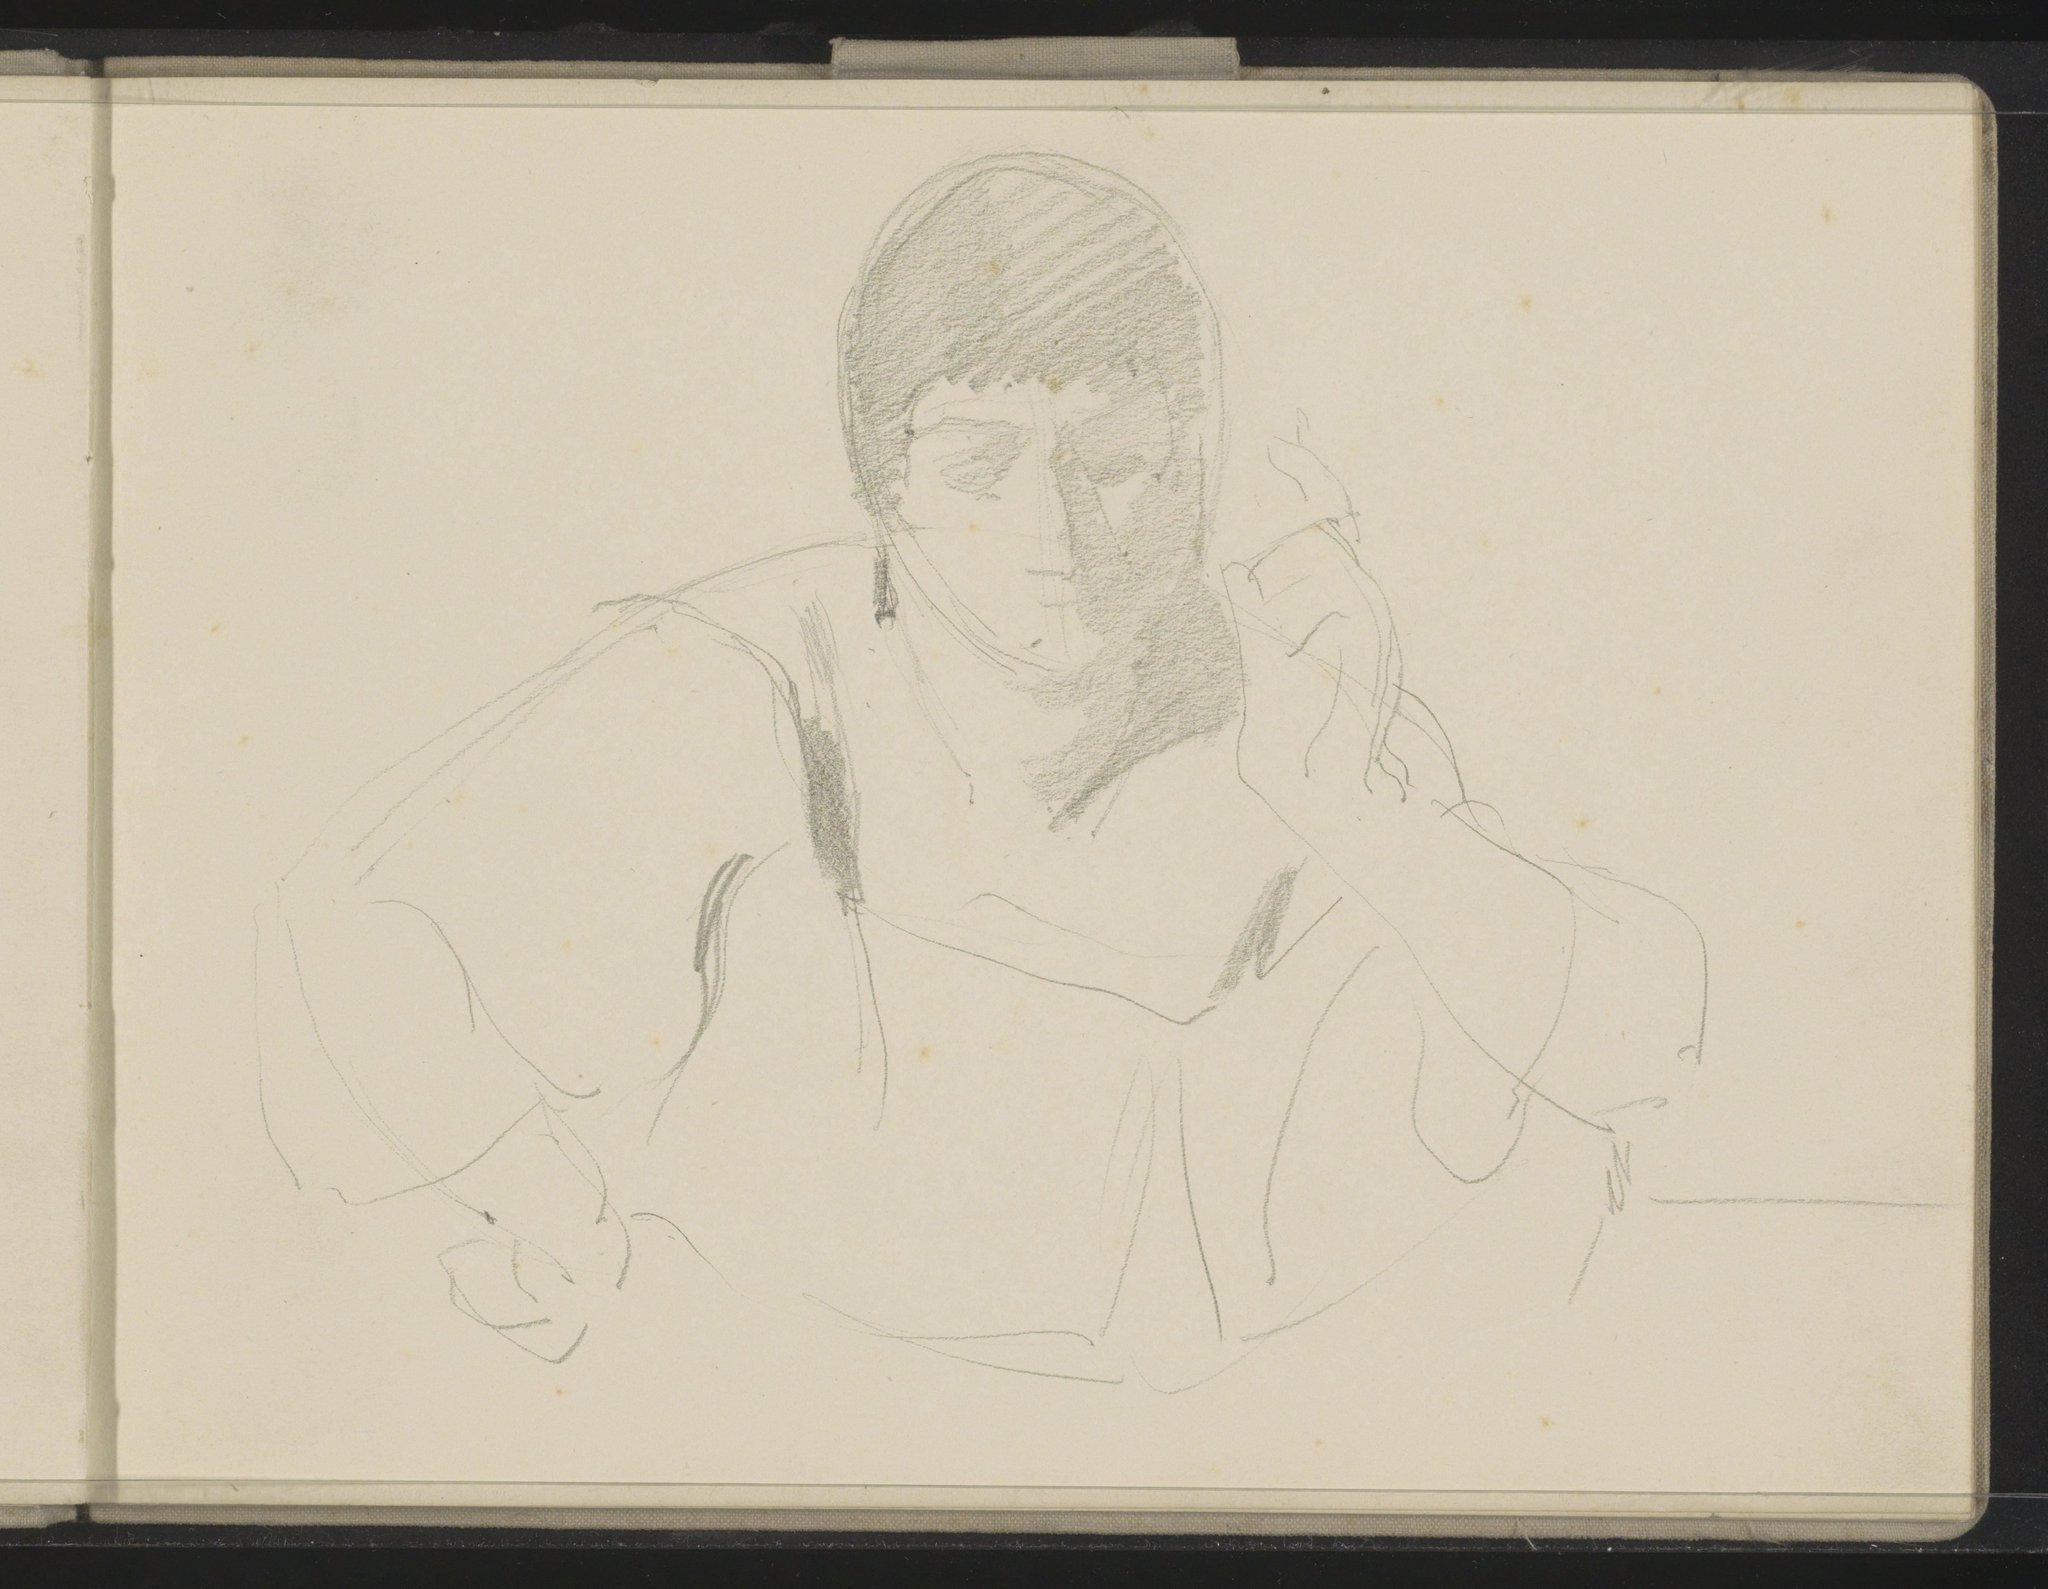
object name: sketchbook leaf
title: Vrouw met een opgeheven hand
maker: ferdinand oldewelt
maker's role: draughtsman, print maker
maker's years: 1857-1935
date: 1908-1923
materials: paper, pencil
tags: adult woman, postures and gestures of the hand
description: Blad 16 recto uit een schetsboek met 35 bladen.